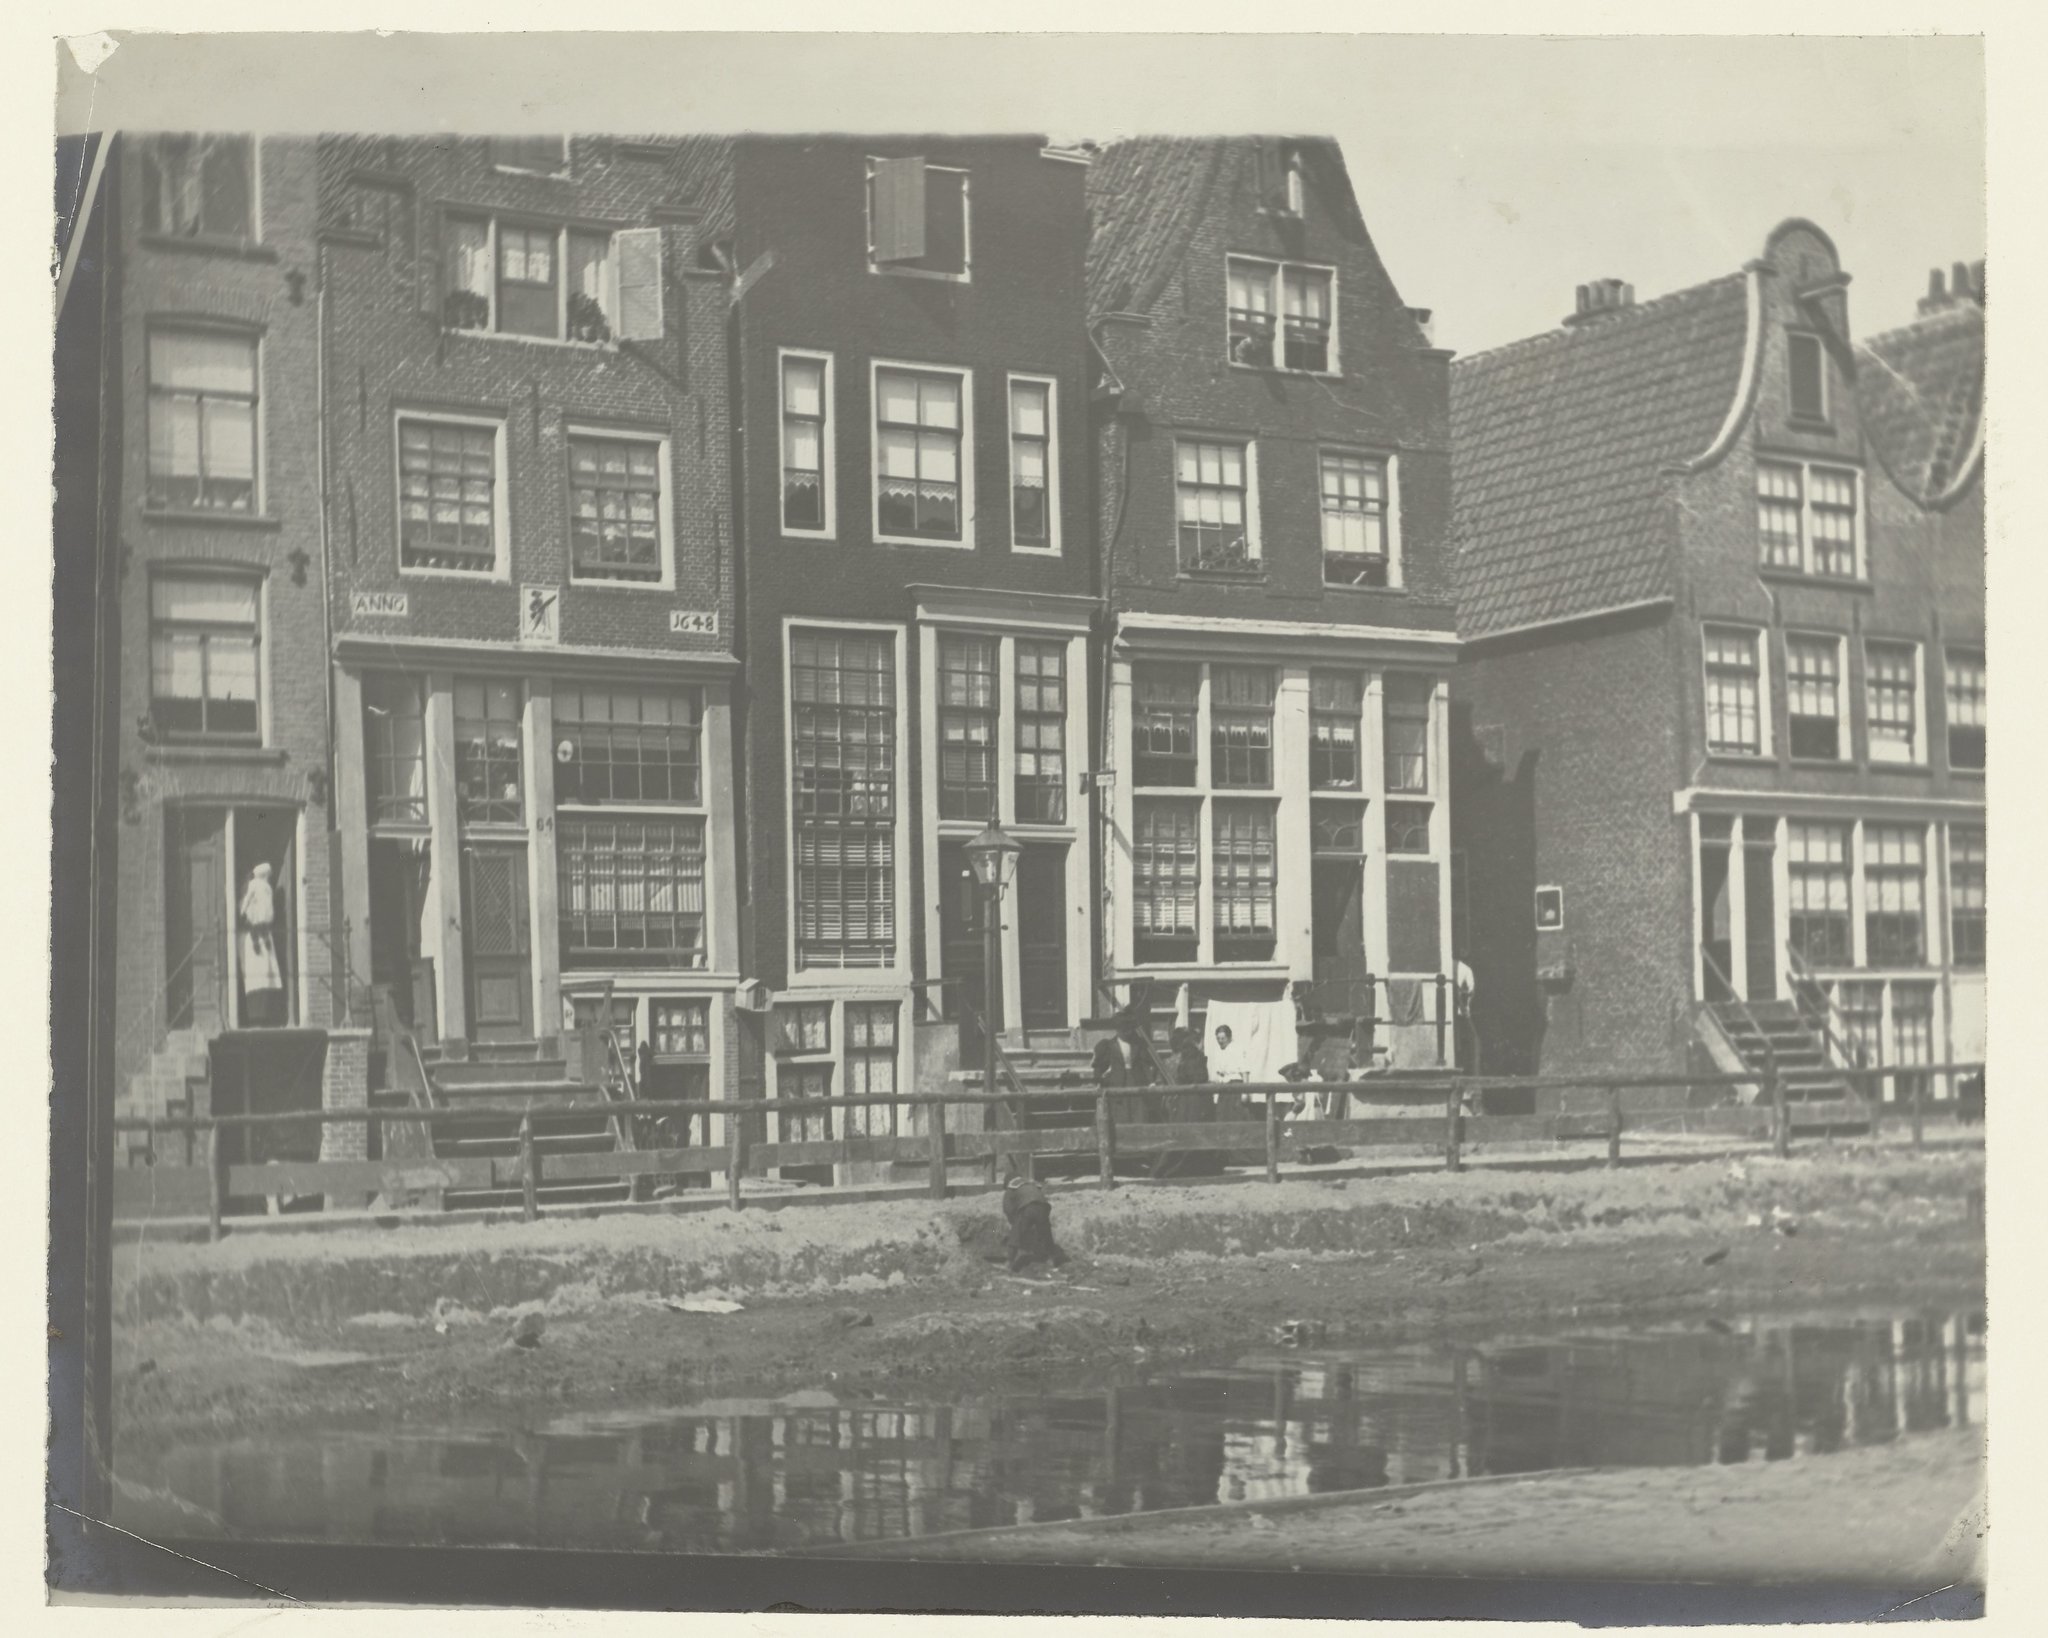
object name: photograph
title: Gezicht op de Palmgracht bij de Kromme Palmstraat in Amsterdam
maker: george hendrik breitner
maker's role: draughtsman, painter, print maker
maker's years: 1857-1923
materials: cardboard, paper, photographic support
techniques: gelatin silver print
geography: amsterdam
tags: canals, waters (in city), the usual house or row of houses, street